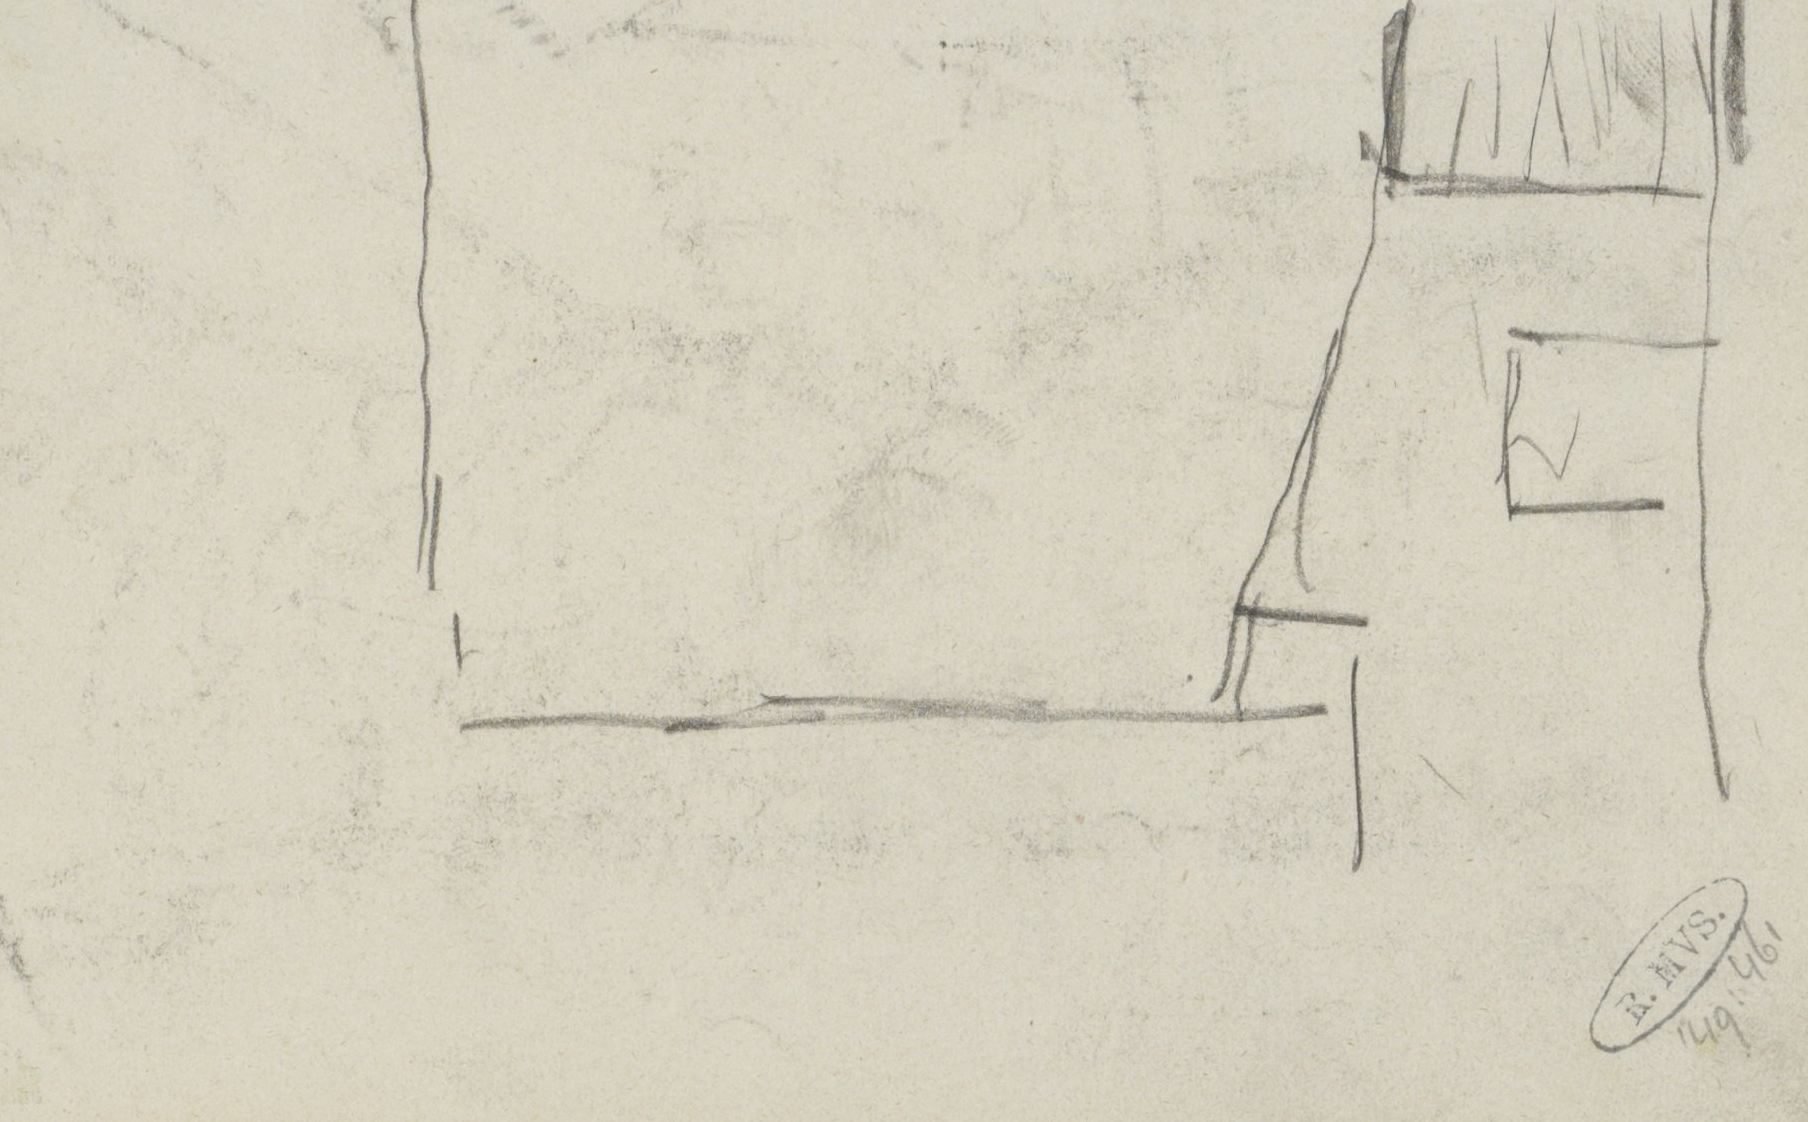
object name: drawing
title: Studie, mogelijk een architectuurstudie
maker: george hendrik breitner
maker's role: draughtsman, painter, print maker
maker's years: 1857-1923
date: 1912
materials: chalk, paper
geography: amsterdam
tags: civic architecture; edifices; dwellings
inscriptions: collector's mark: Lugt 2228